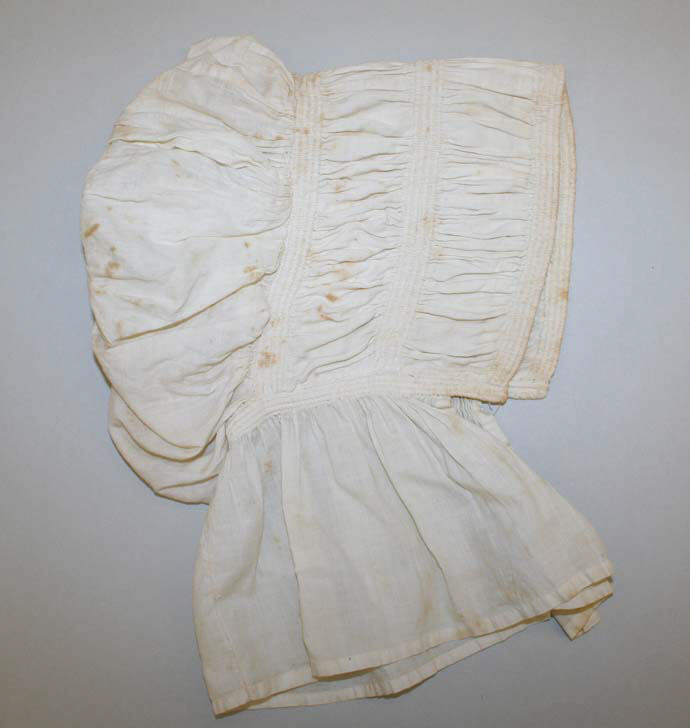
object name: bonnet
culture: american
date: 1834-1866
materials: cotton